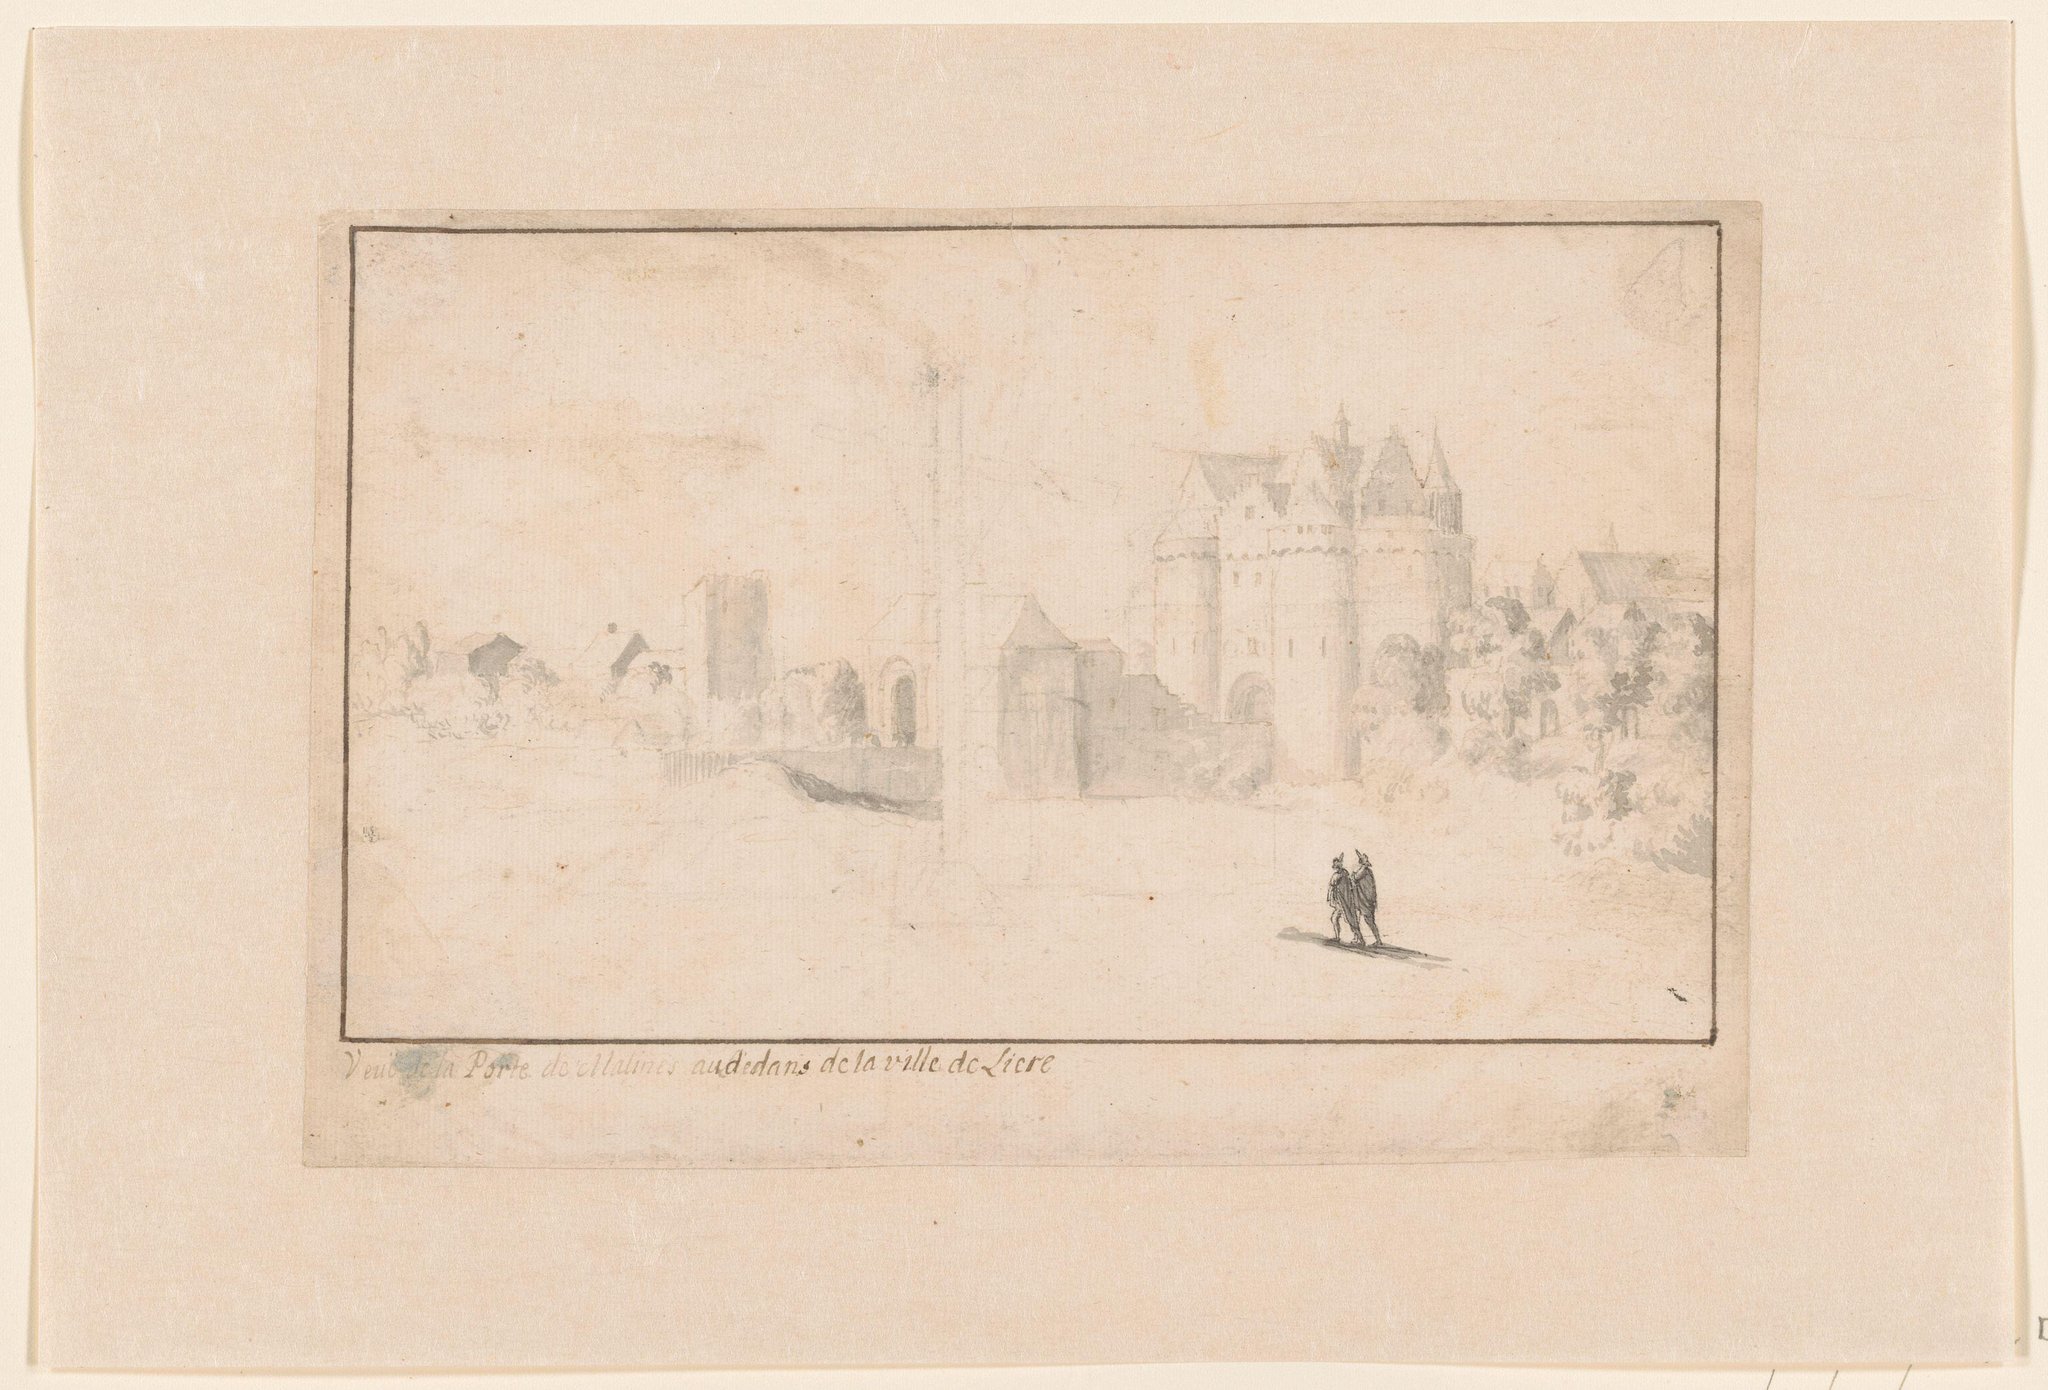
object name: drawing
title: Gezicht op de Mechelse Poort in Lier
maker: Anonymous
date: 1700-1799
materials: ink, paper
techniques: brush, drawing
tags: city-gate, lierre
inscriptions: watermark: ‘I P F H’